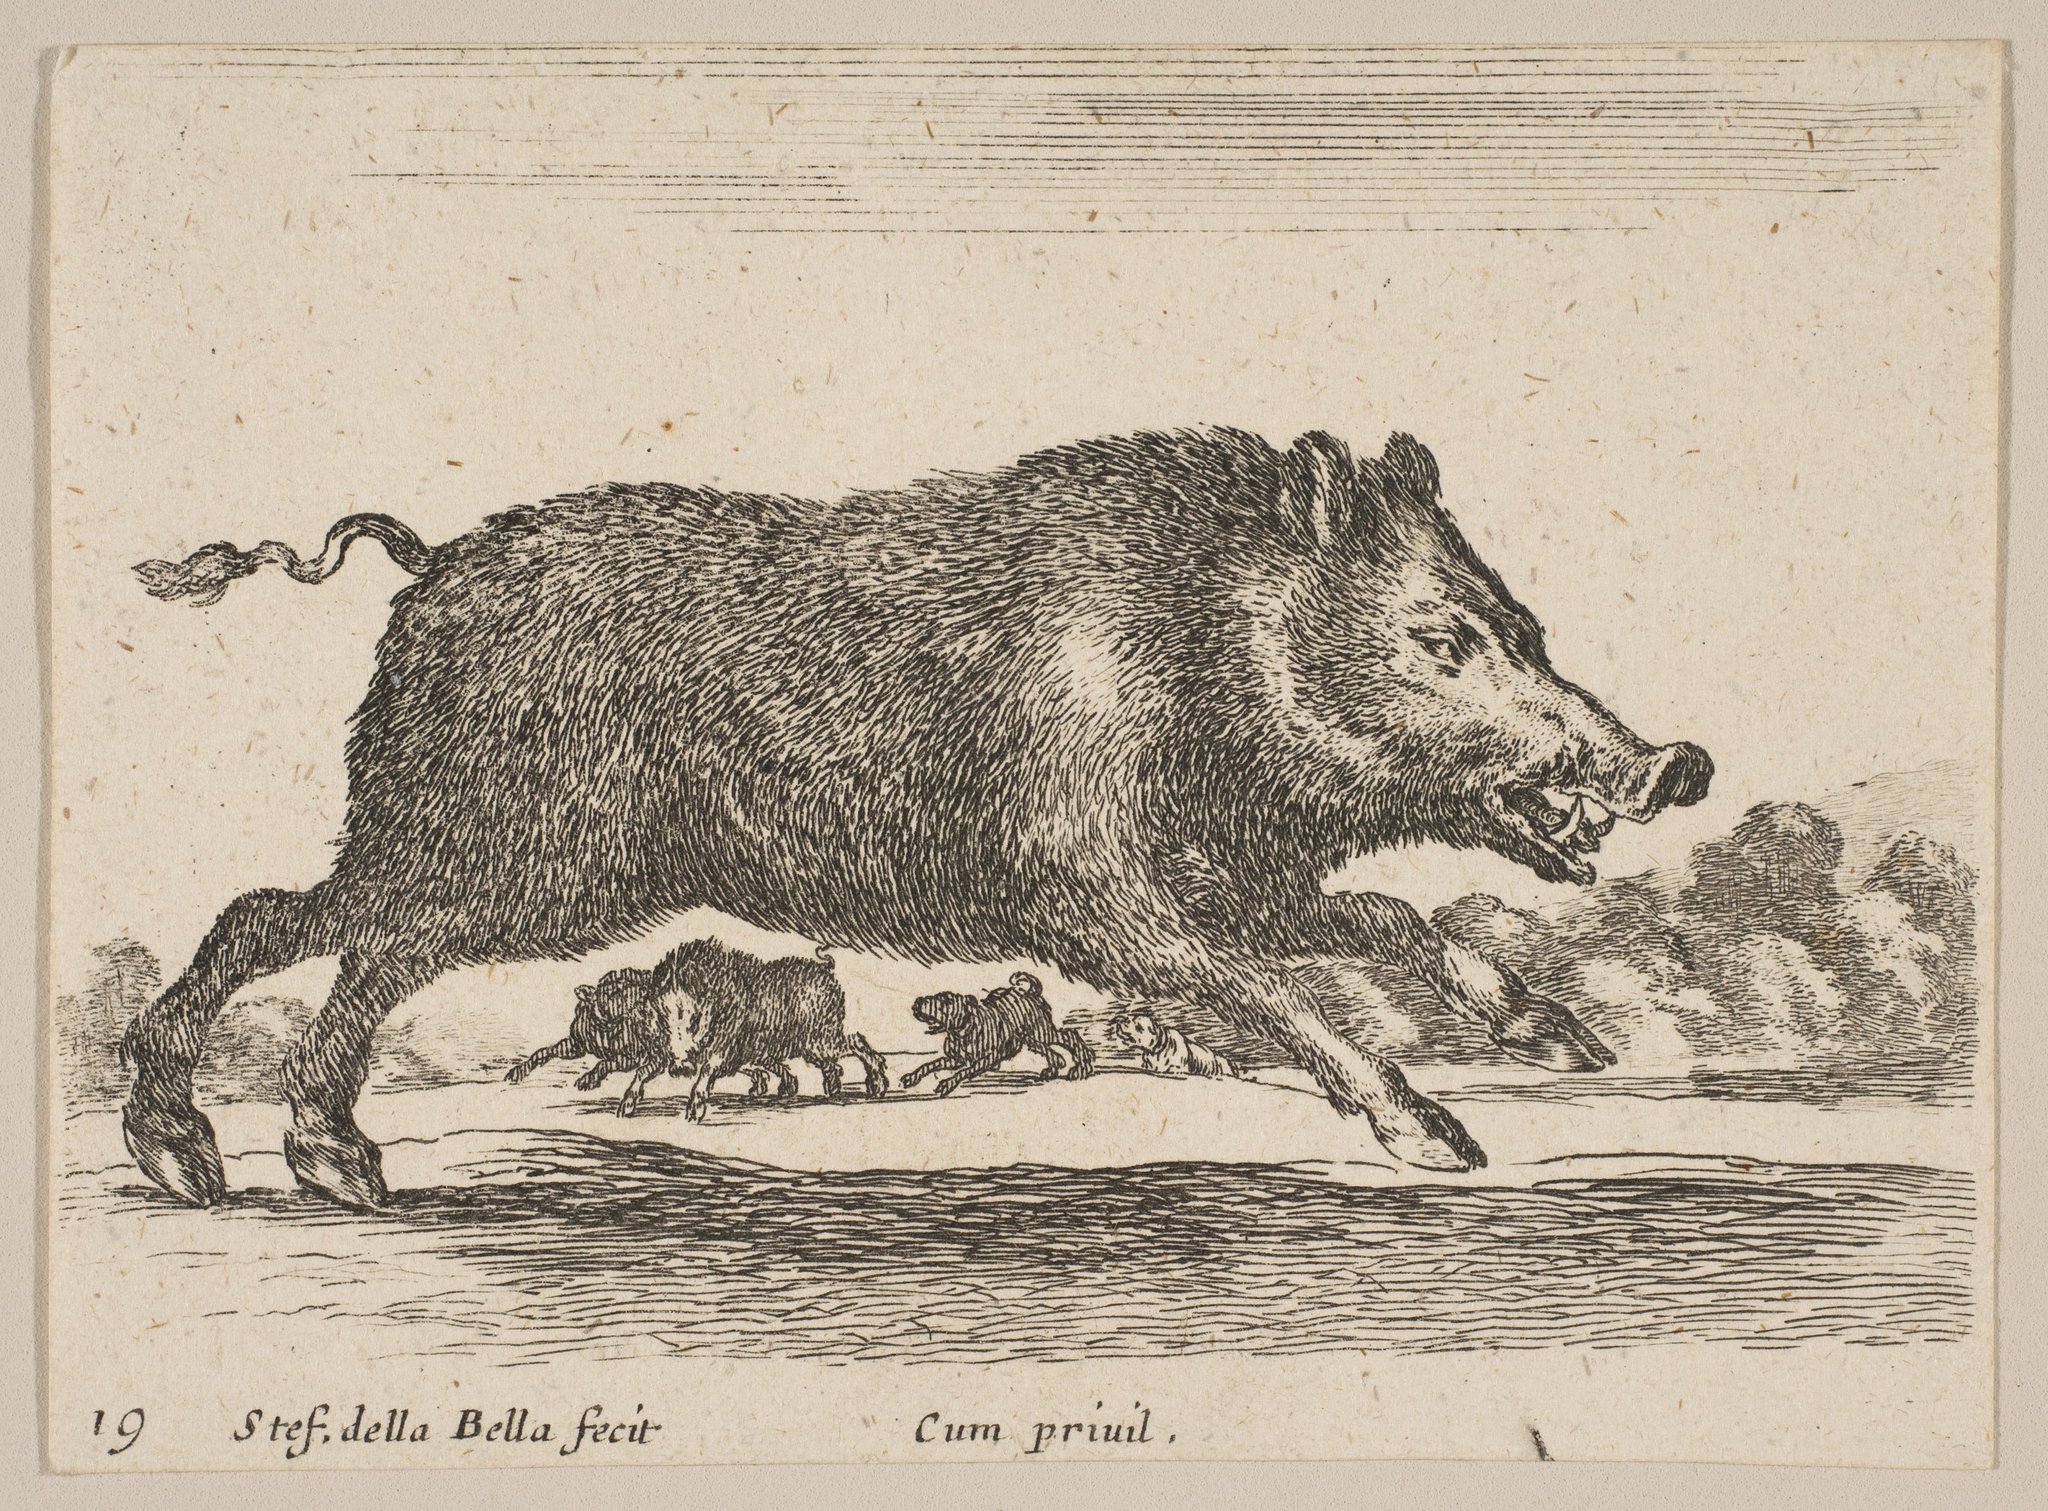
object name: print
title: Plate 19: Wild Boar, from "Various animals" (Diversi animali)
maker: stefano della bella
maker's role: artist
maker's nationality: italian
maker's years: 1610-1664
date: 1641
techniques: etching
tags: boars